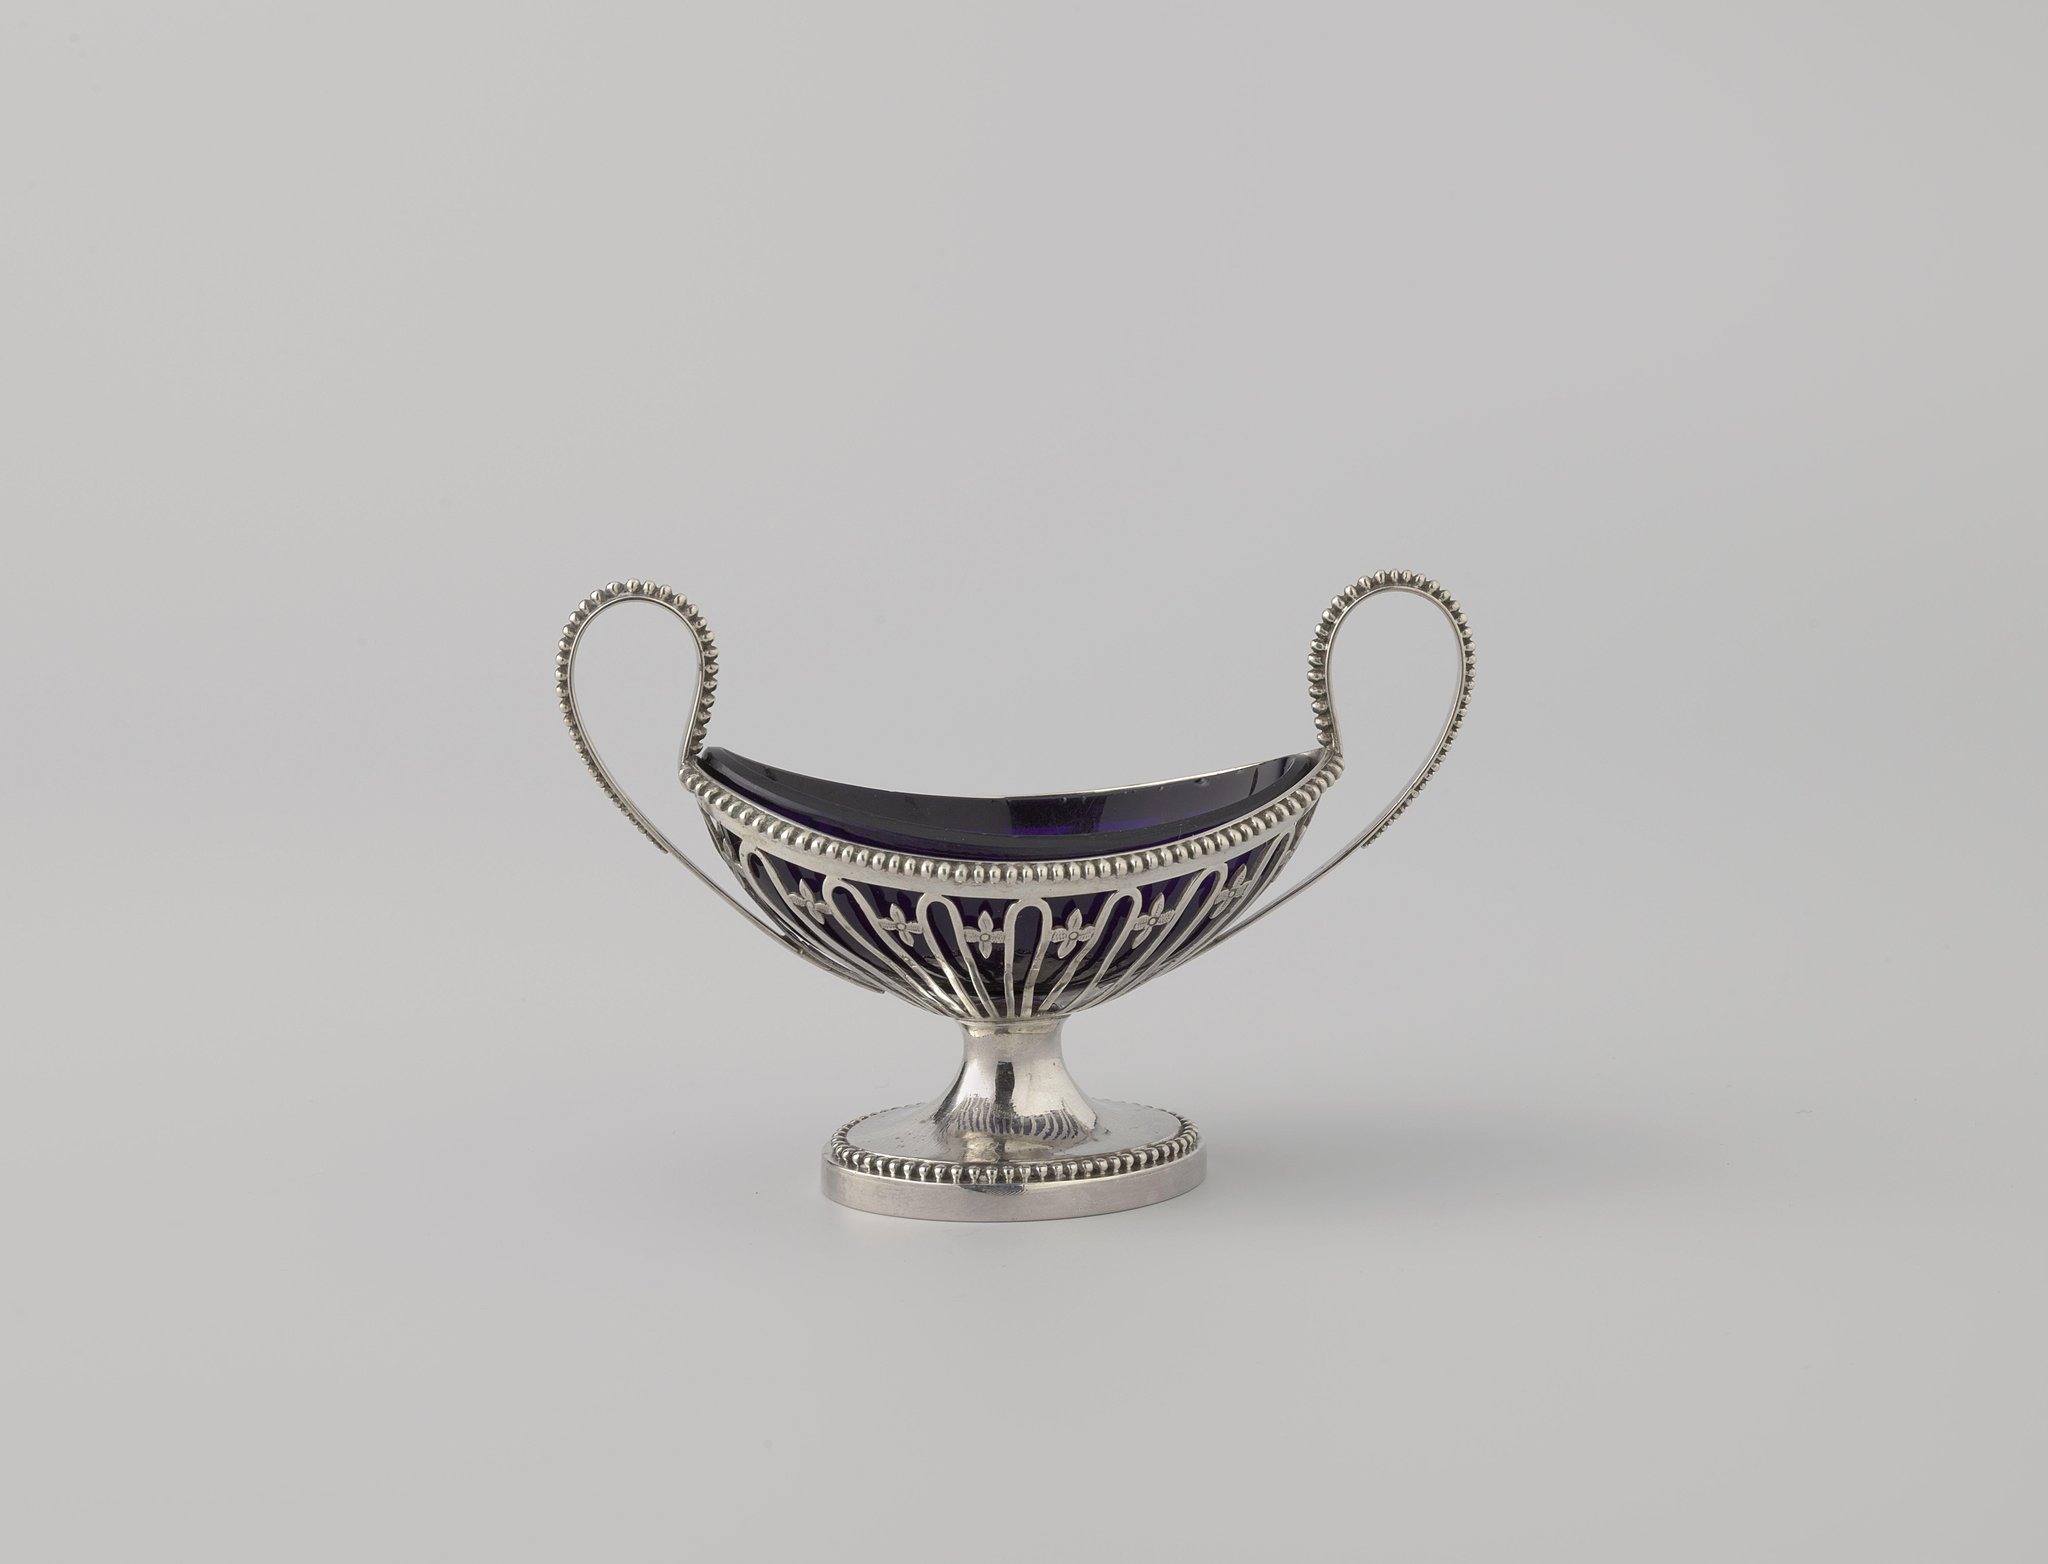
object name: salt condiment vessel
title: Binnenbak van blauw glas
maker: nathanael teuter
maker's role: silversmith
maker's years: 1767-1831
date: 1805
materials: glass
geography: amsterdam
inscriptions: alloy mark, maker's mark, duty mark, town mark, date letter: ‘W’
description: Binnenbak van blauw glas, is met krammetjes hersteld.